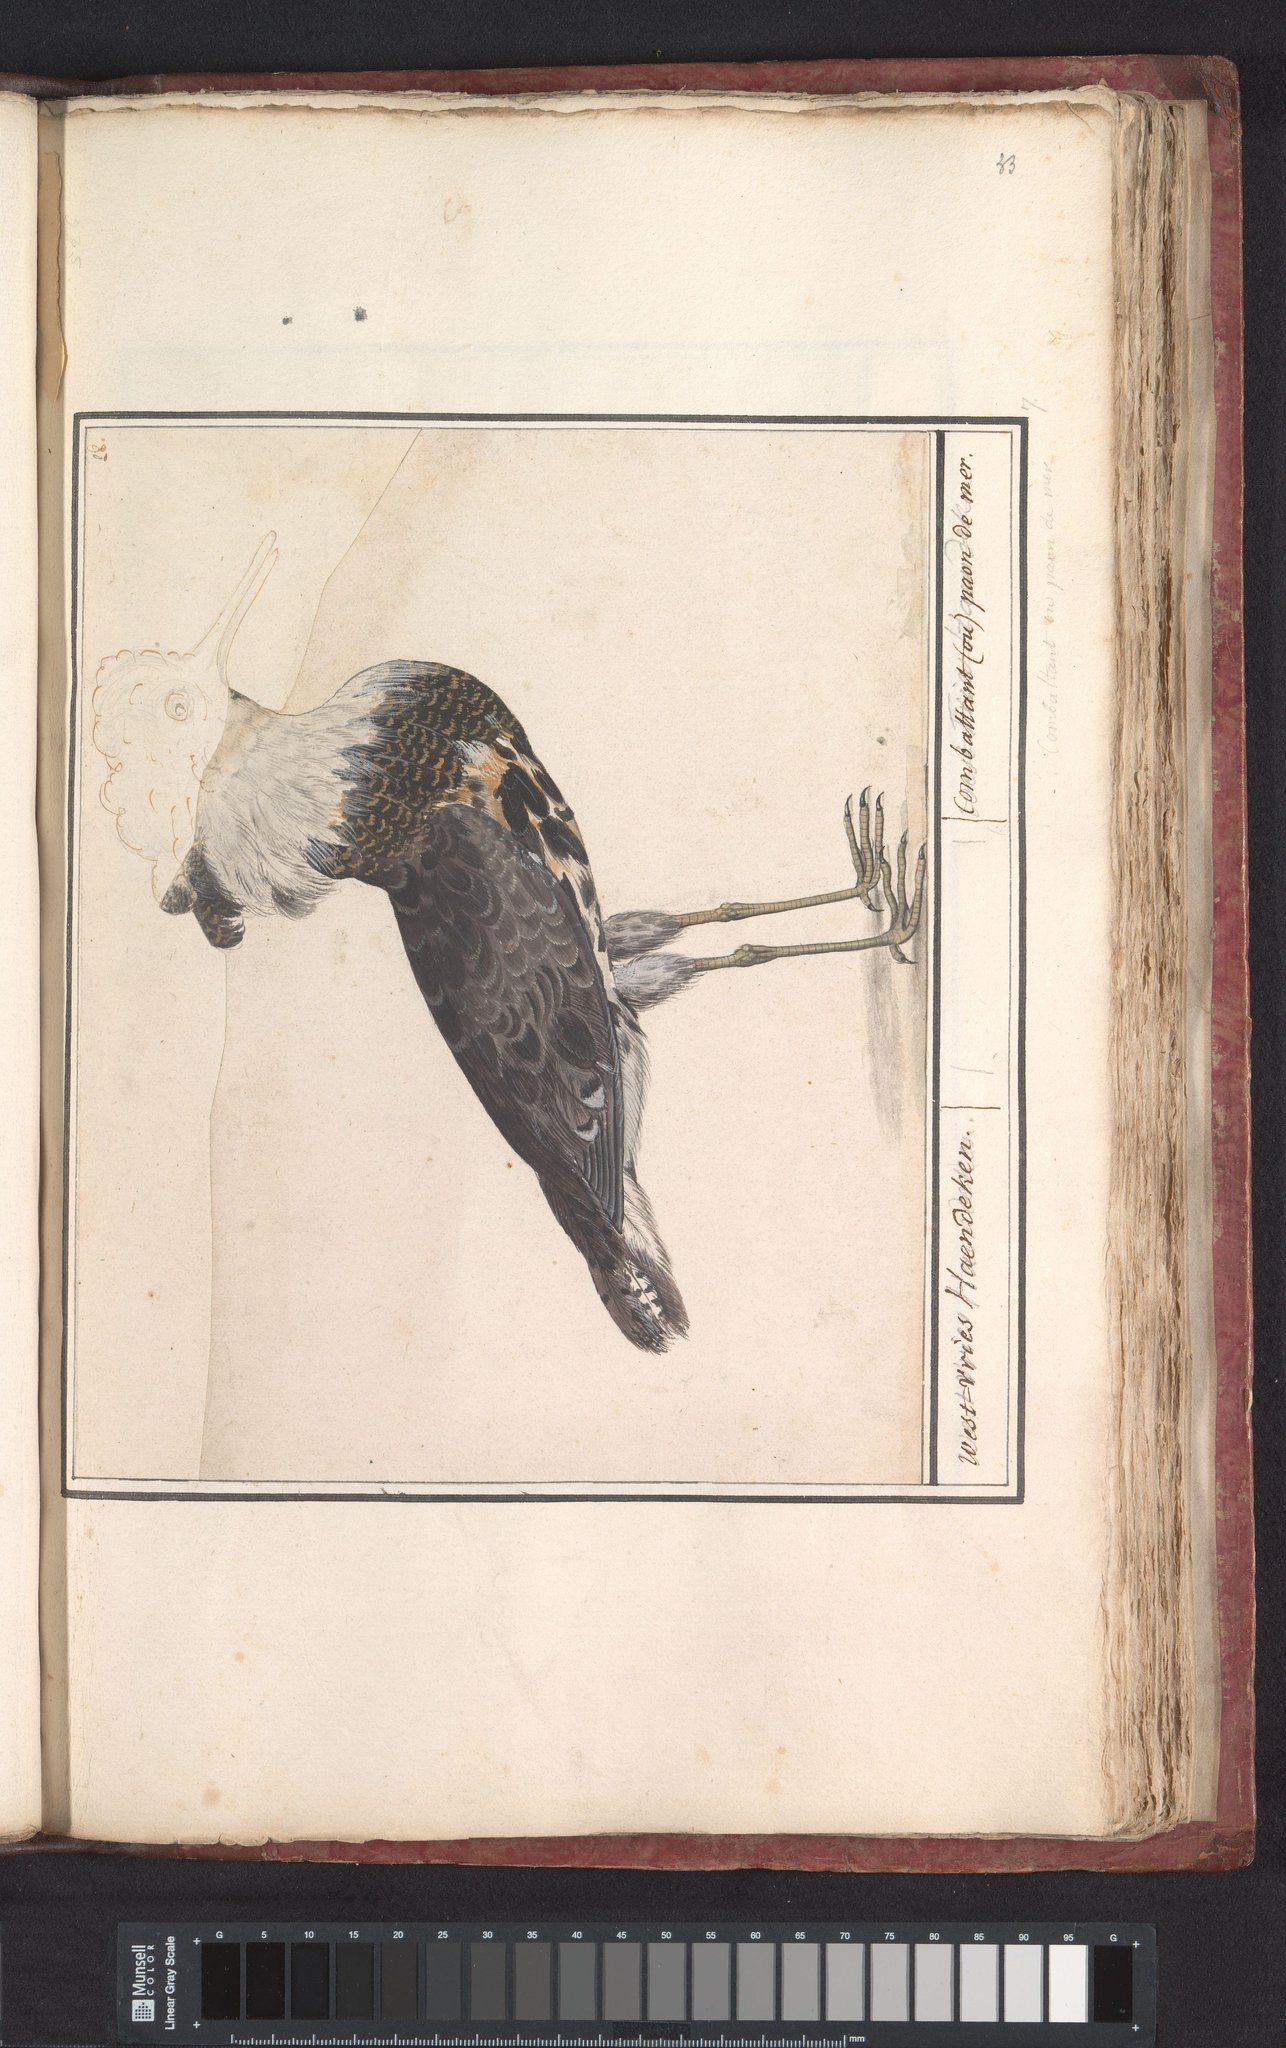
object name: drawing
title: Kemphaan (Philomachus pugnax)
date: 1596-1610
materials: chalk, paint, paper, pencil, watercolor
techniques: brush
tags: shore-birds and wading-birds: ruff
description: Kemphaan. Genummerd rechtsboven: 28. Onderdeel van het derde album met tekeningen van vogels. Vijfde van twaalf albums met tekeningen van dieren, vogels en planten bekend rond 1600, gemaakt in opdracht van keizer Rudolf II. Met toelichting in Nederlands, Latijn en Frans.